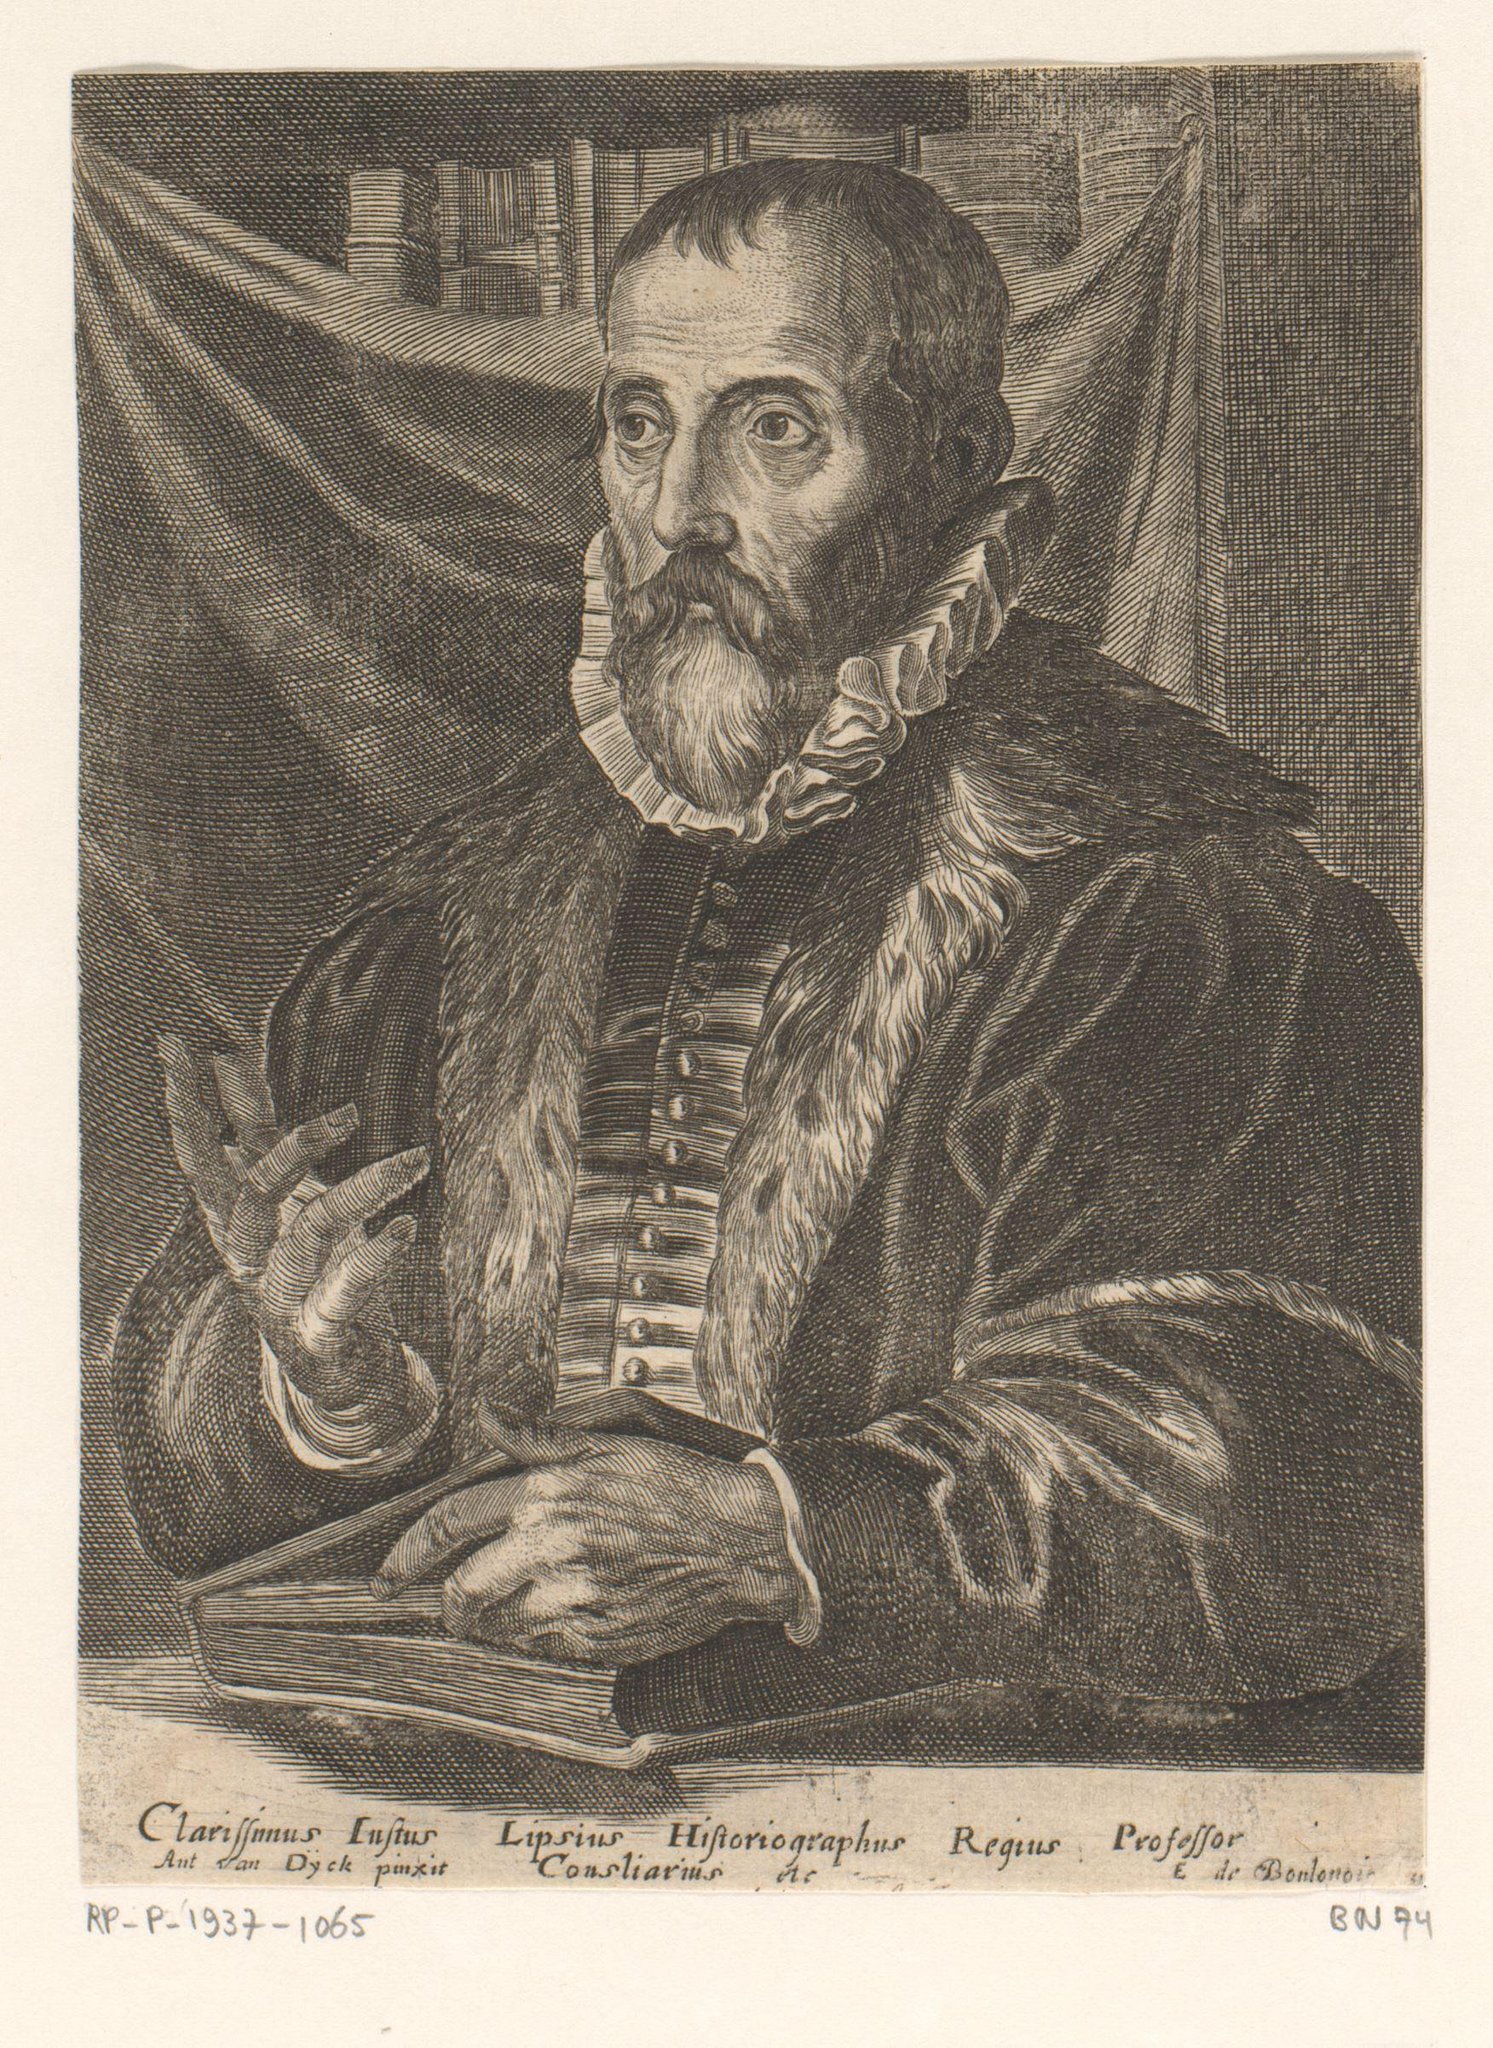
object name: book illustration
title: Clarissinnnus Iustus Lipsius (...)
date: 1682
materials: paper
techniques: engraving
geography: brussels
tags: louvain, justus lipsius, scholar, philosopher, historical persons, professor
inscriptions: collector's mark: Lugt 2228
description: Prent uit: Bullert, Isaac. Académie des Sciences et Arts contenant les vies et éloges his. des hommes illustres qui ont excellé en ces professions depuis environ quatre siècles. Brussel: Foppens, François, 1682. Het boek werd in 1682 eveneens in Amsterdam uitgegeven door de erfgenamen van Daniel Elzevier. Deze portretten dienen ter illustratie van de biografie van een kunstenaar of geleerde. De meeste portretten werden door Nicolas de Larmessin vervaardigd (162), 93 door De Boulonois en een derde door ongeïdentificeerde prentmakers. Dit betreft een illustratie op p. 193, deel II.